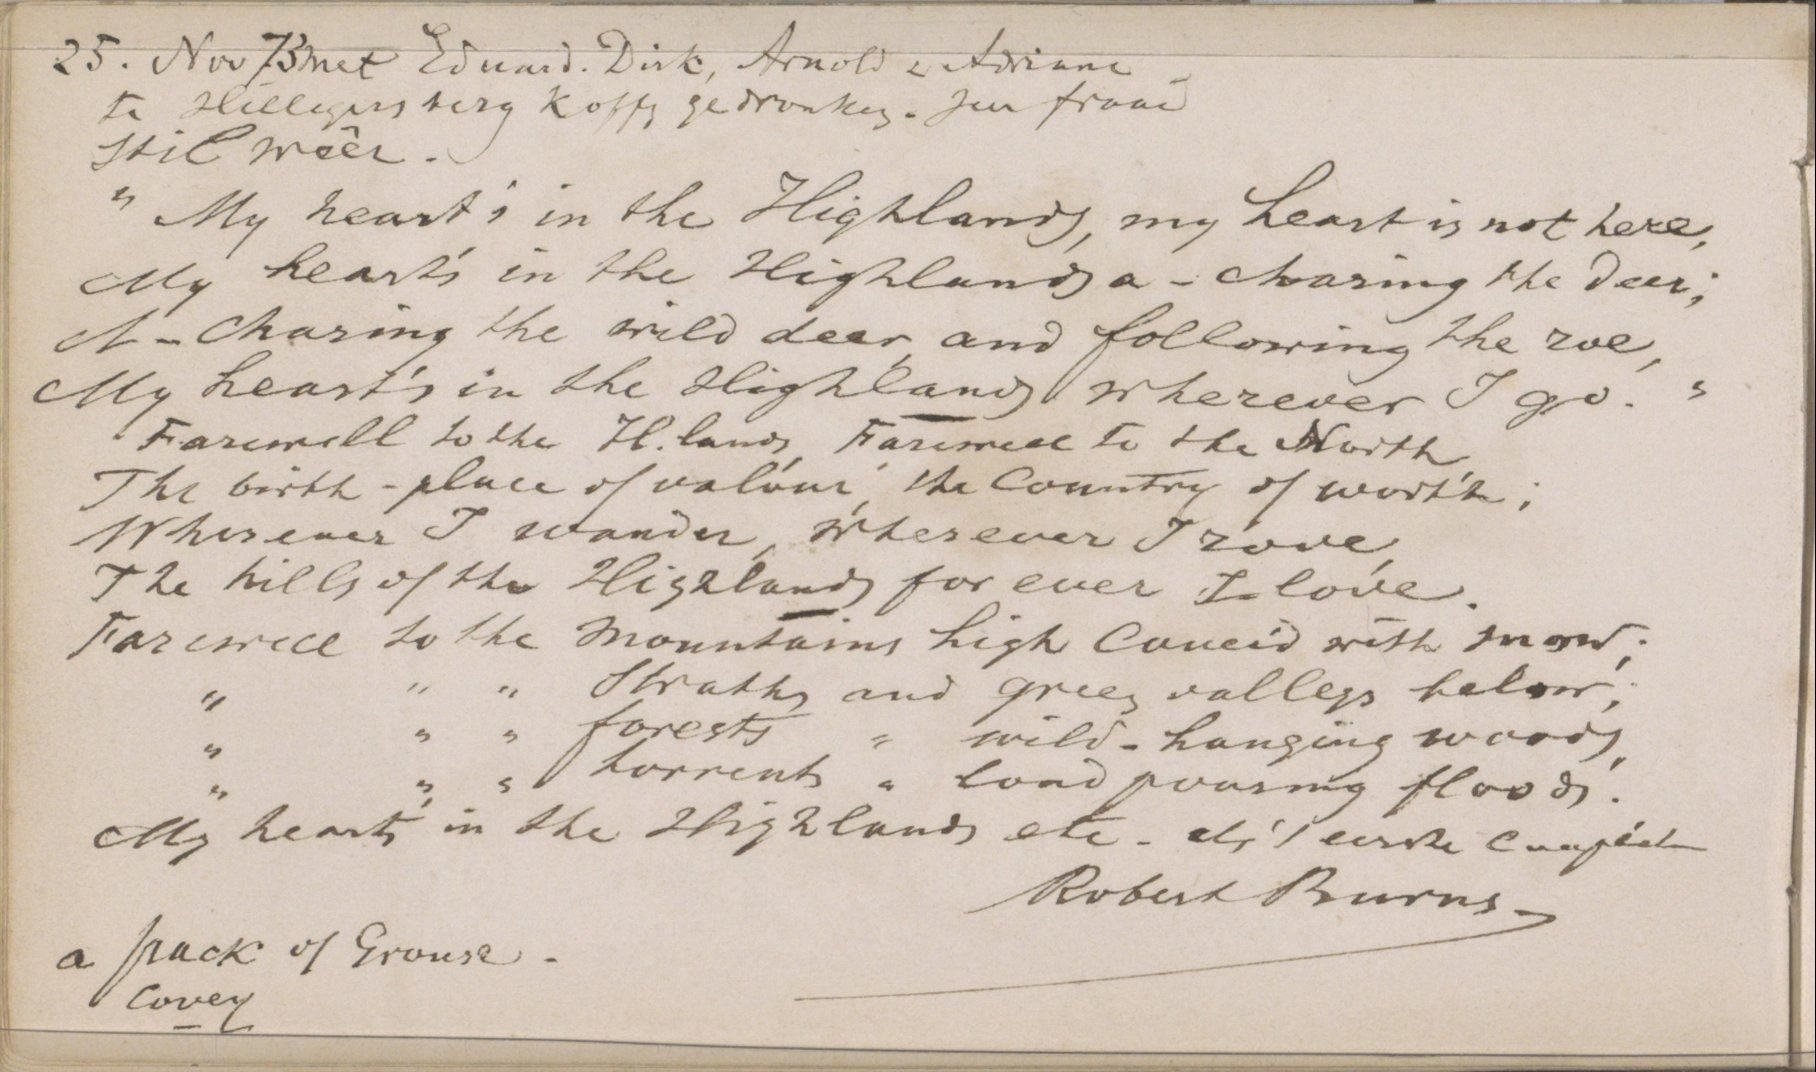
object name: sketchbook leaf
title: Groep rokende en fluitspelende mannen in een bos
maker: johannes tavenraat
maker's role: draughtsman, painter, print maker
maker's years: 1809-1881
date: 1873-1876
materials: ink, paper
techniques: brush, pen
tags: walking-stick, staff, adult man, pipe ~ tobacco, forest, wood, flute, aulos, tibia - cc - out of doors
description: Blad 23 verso uit een schetsboek met 46 bladen.